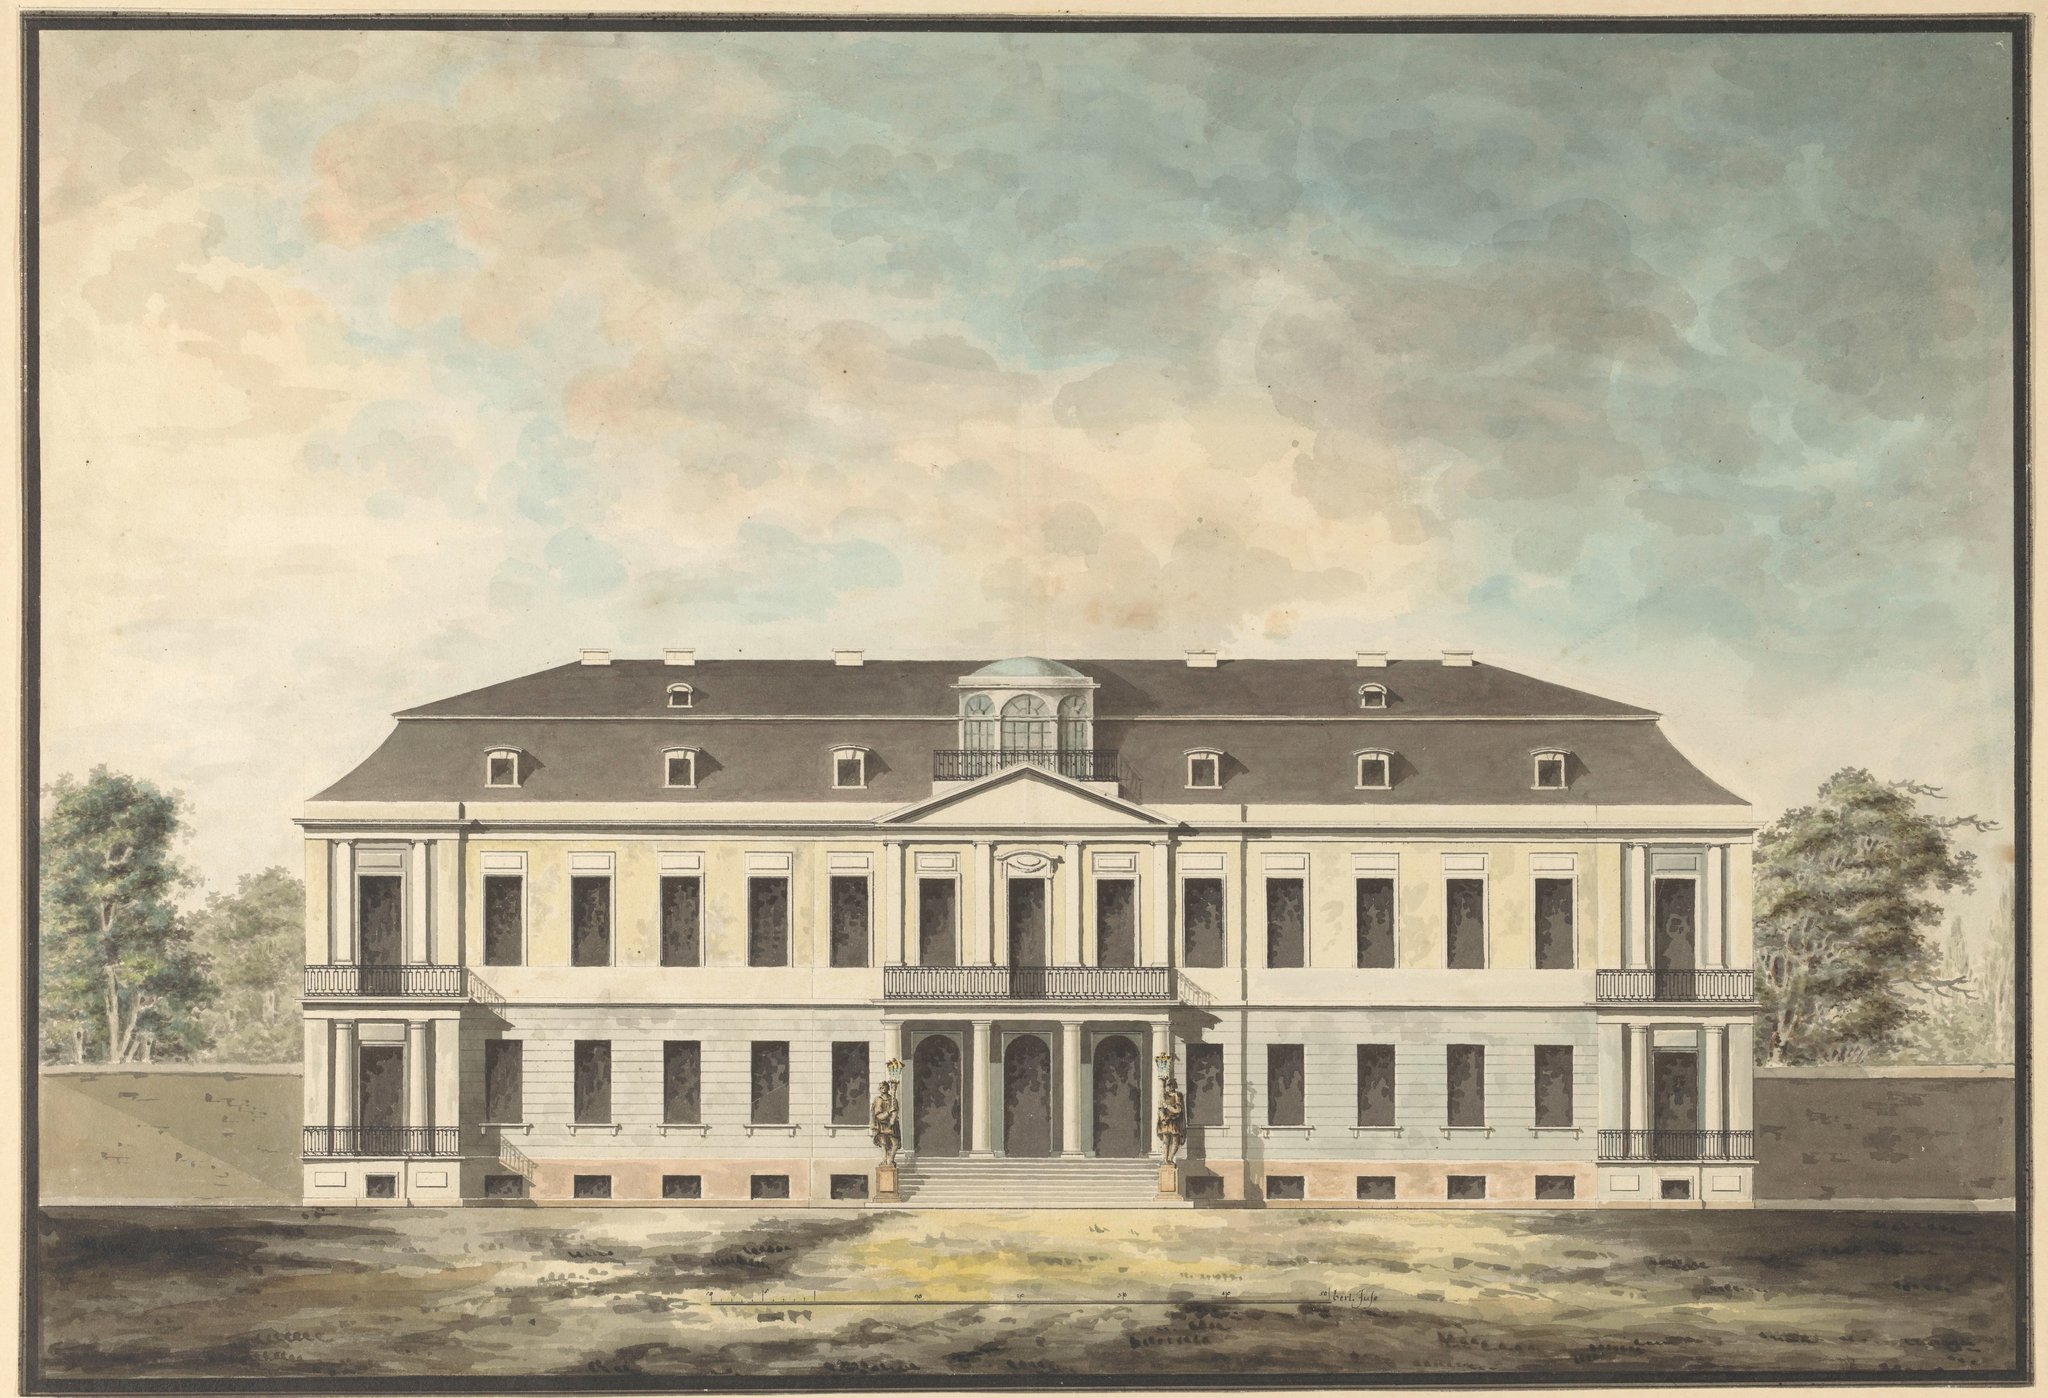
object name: drawing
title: Ontwerp voor de voorgevel van een villa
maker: wybrand tollenaar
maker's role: draughtsman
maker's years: 1778-1852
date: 1788-1852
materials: ink, paper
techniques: brush, pen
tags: façade (of house or building), civic architecture; edifices; dwellings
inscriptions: collector's mark: Lugt 2228